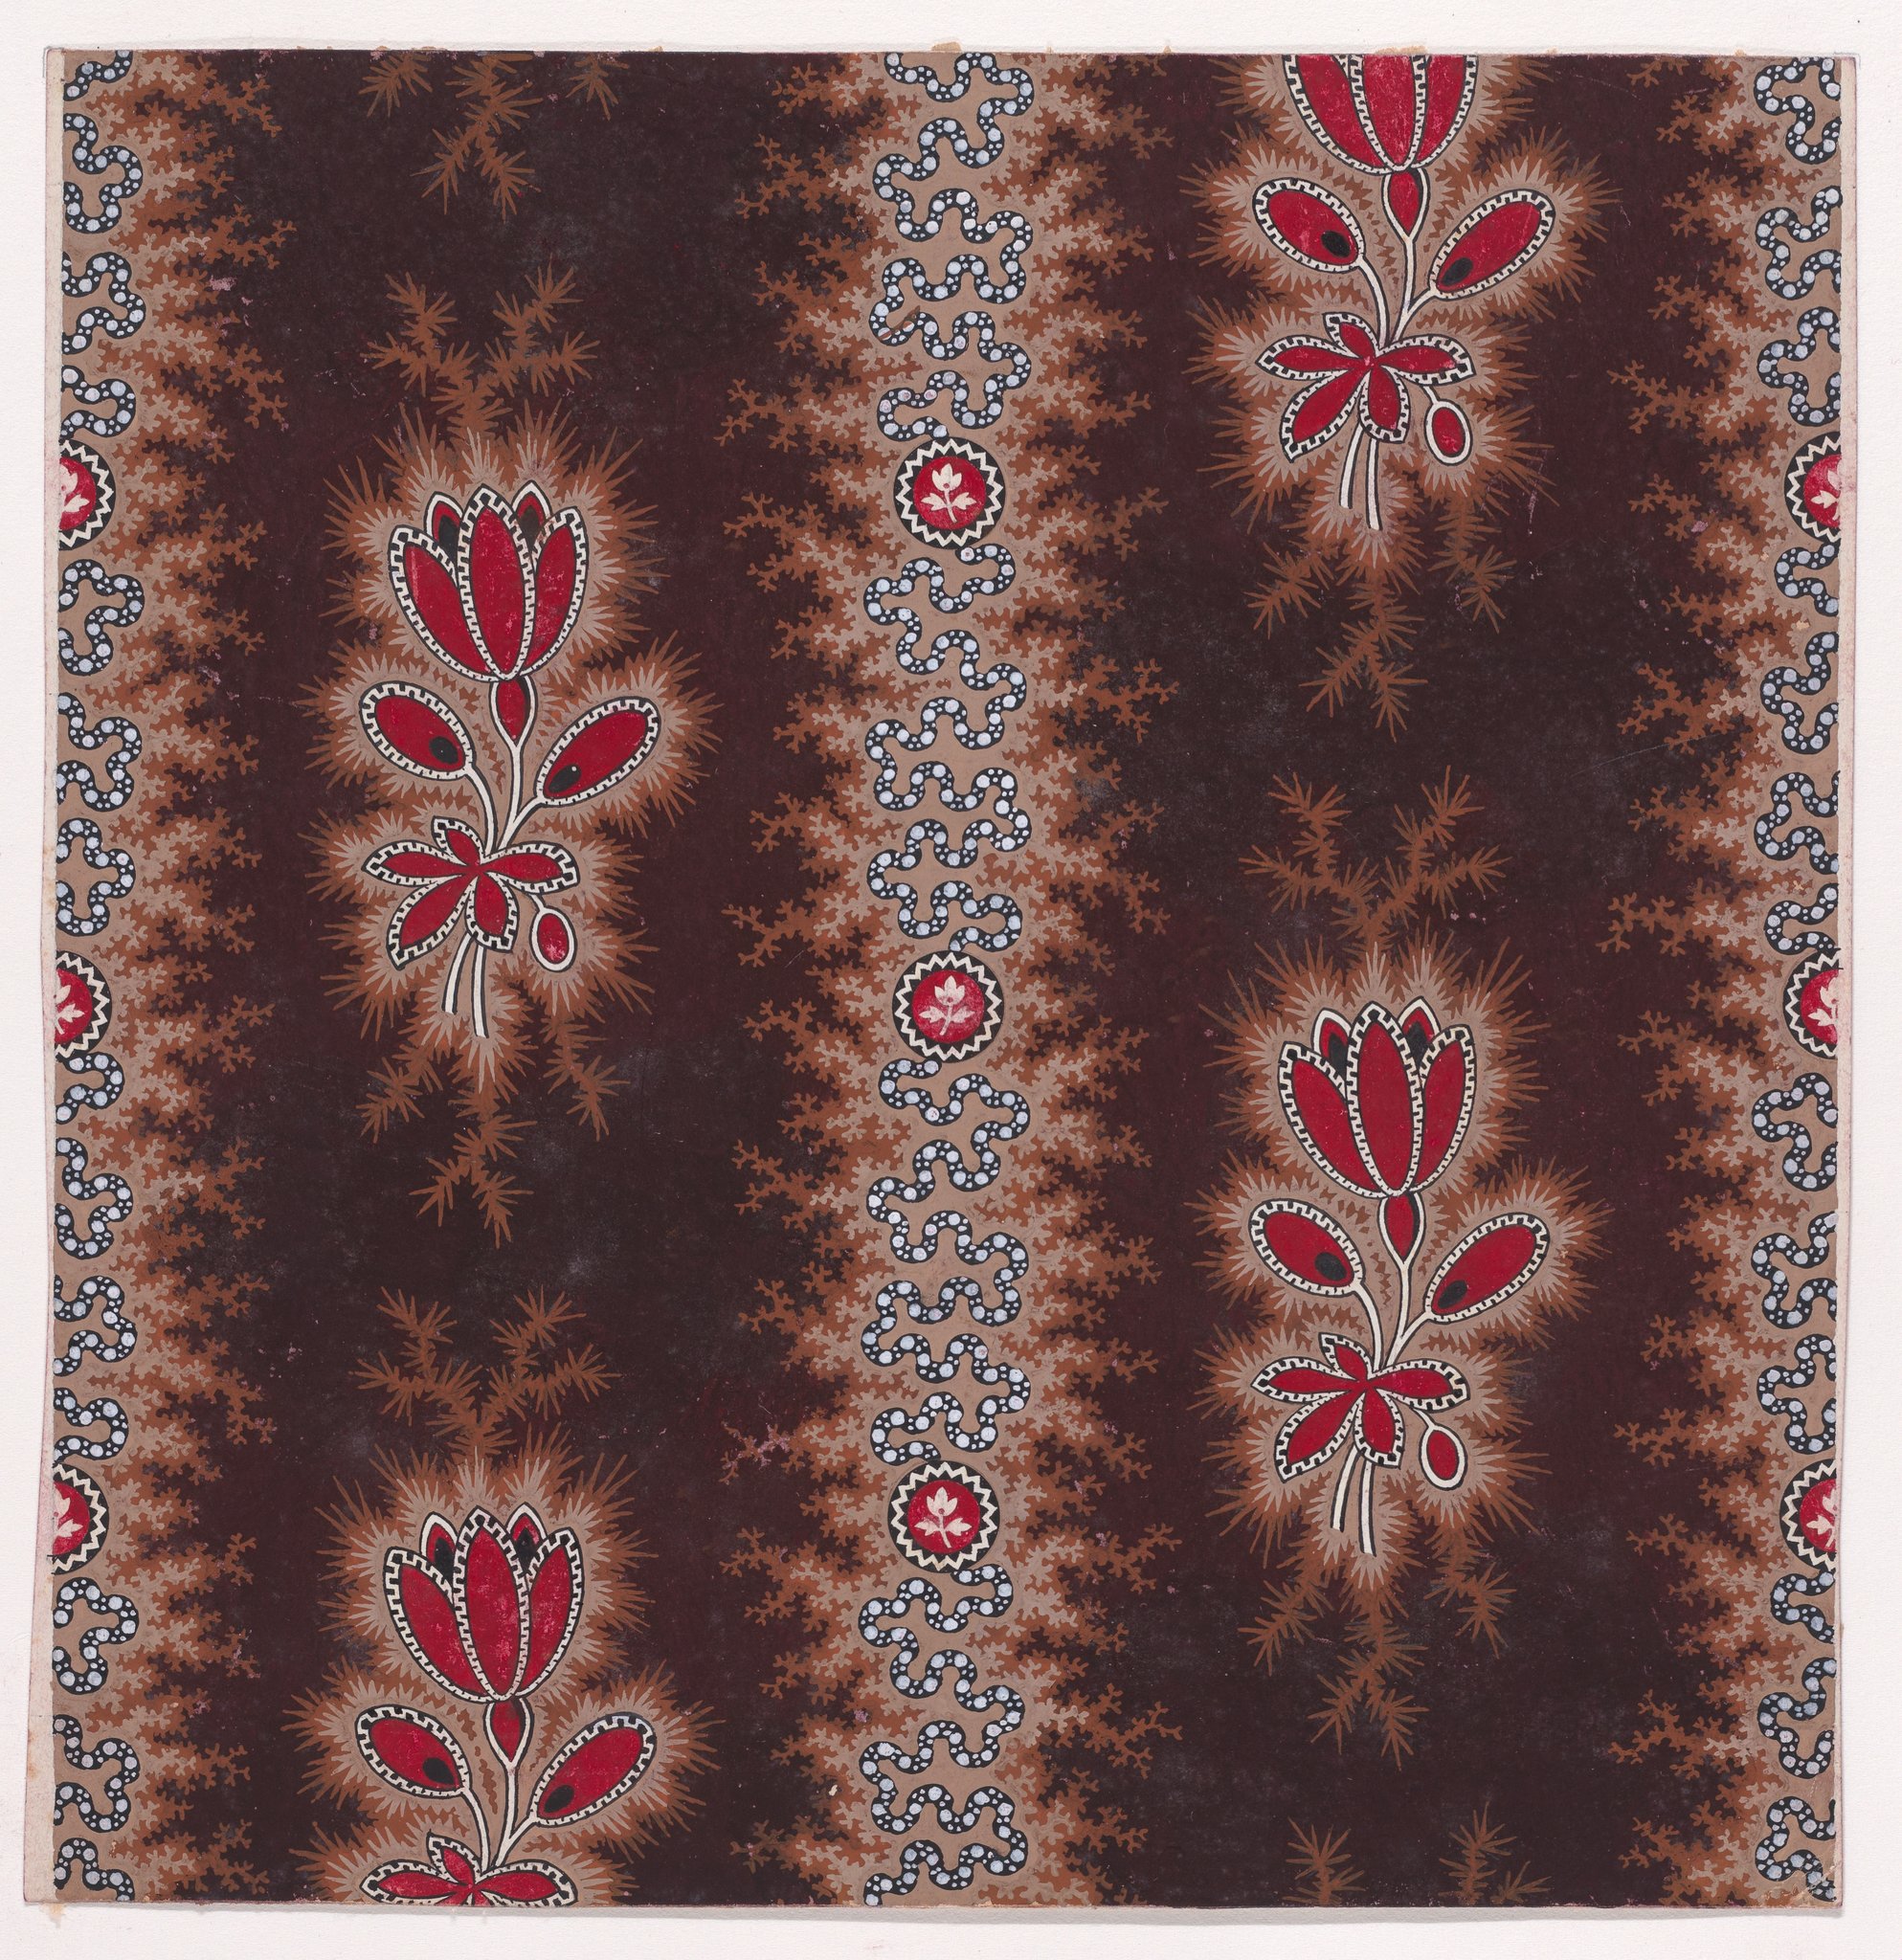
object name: drawing ornament architecture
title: Textile Design with Vertical Rows of Bunches of Stylized Flowers and Stems with Leaves Framed by a Shade of Thorns Separated by Vertical Garlands of Branches with an Undulating Ribbon with Pearls and Small Stylized Flowers Inside a Circular Frame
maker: anonymous, alsatian, 19th century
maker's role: artist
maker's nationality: alsatian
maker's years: 1800-1900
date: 1840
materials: gouache